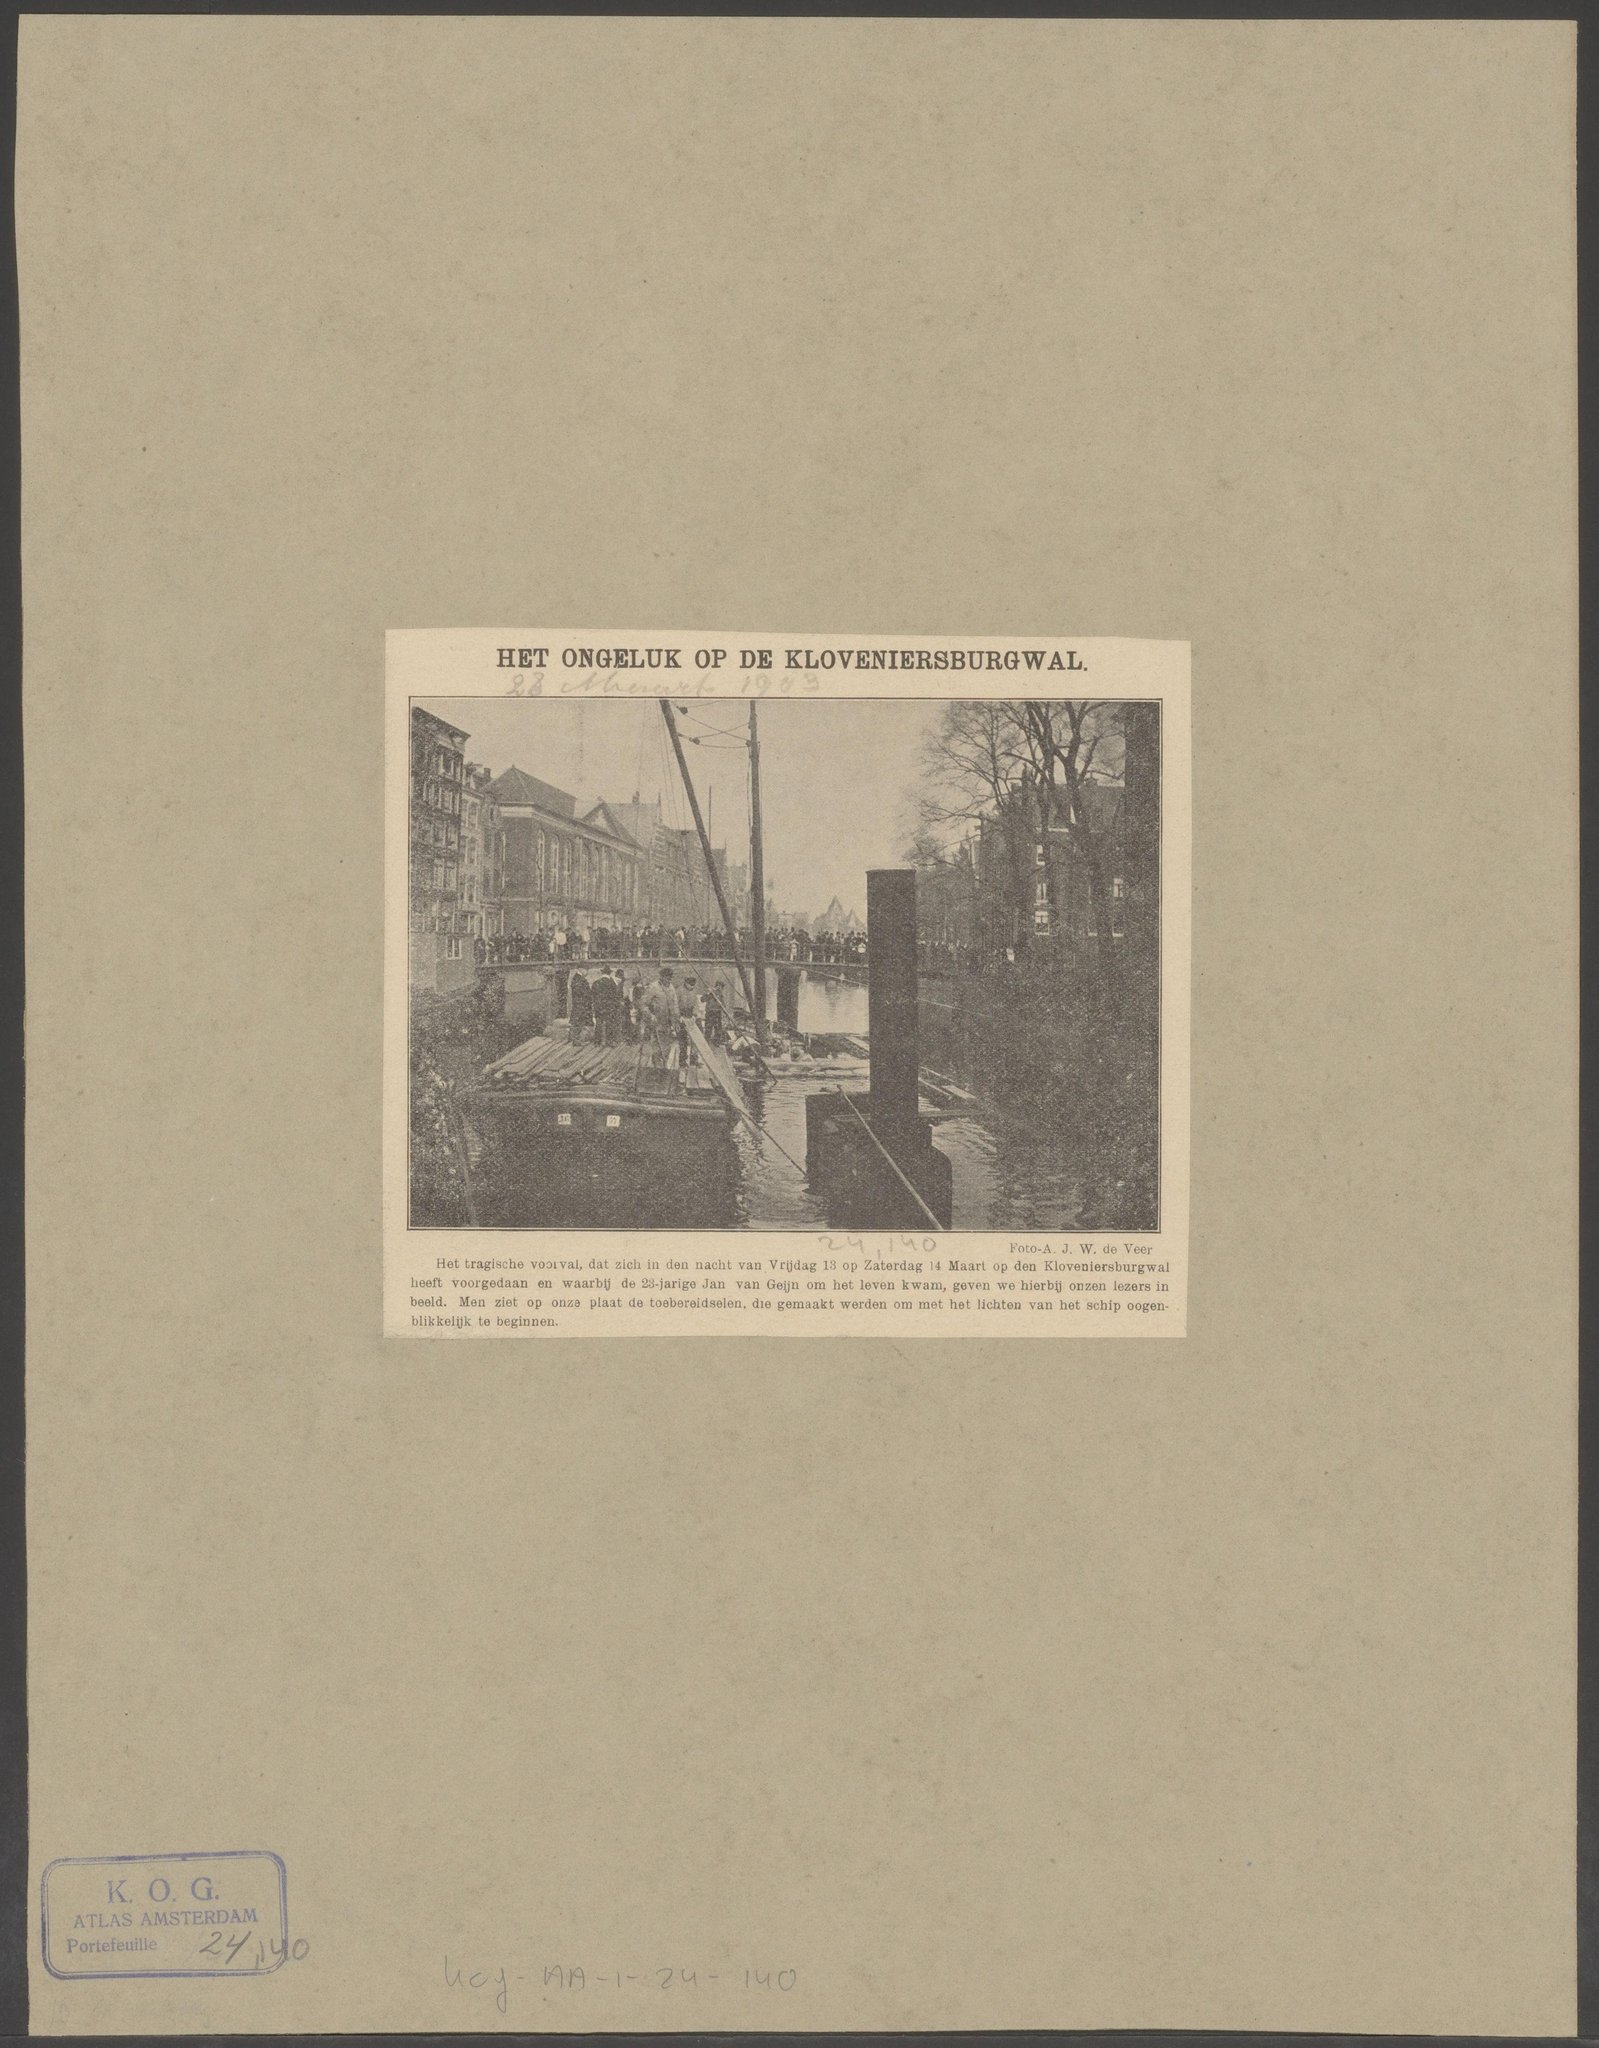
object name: photomechanical print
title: Het ongeluk op de Kloveniersburgwal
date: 1903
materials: paper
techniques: letterpress printing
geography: amsterdam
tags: salvaging a wreck, canals, waters (in city), steamship, motorship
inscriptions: collector's mark: Lugt 1641b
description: Onderwerpsrubriek binnen de Atlas Amsterdam: Ongelukken.